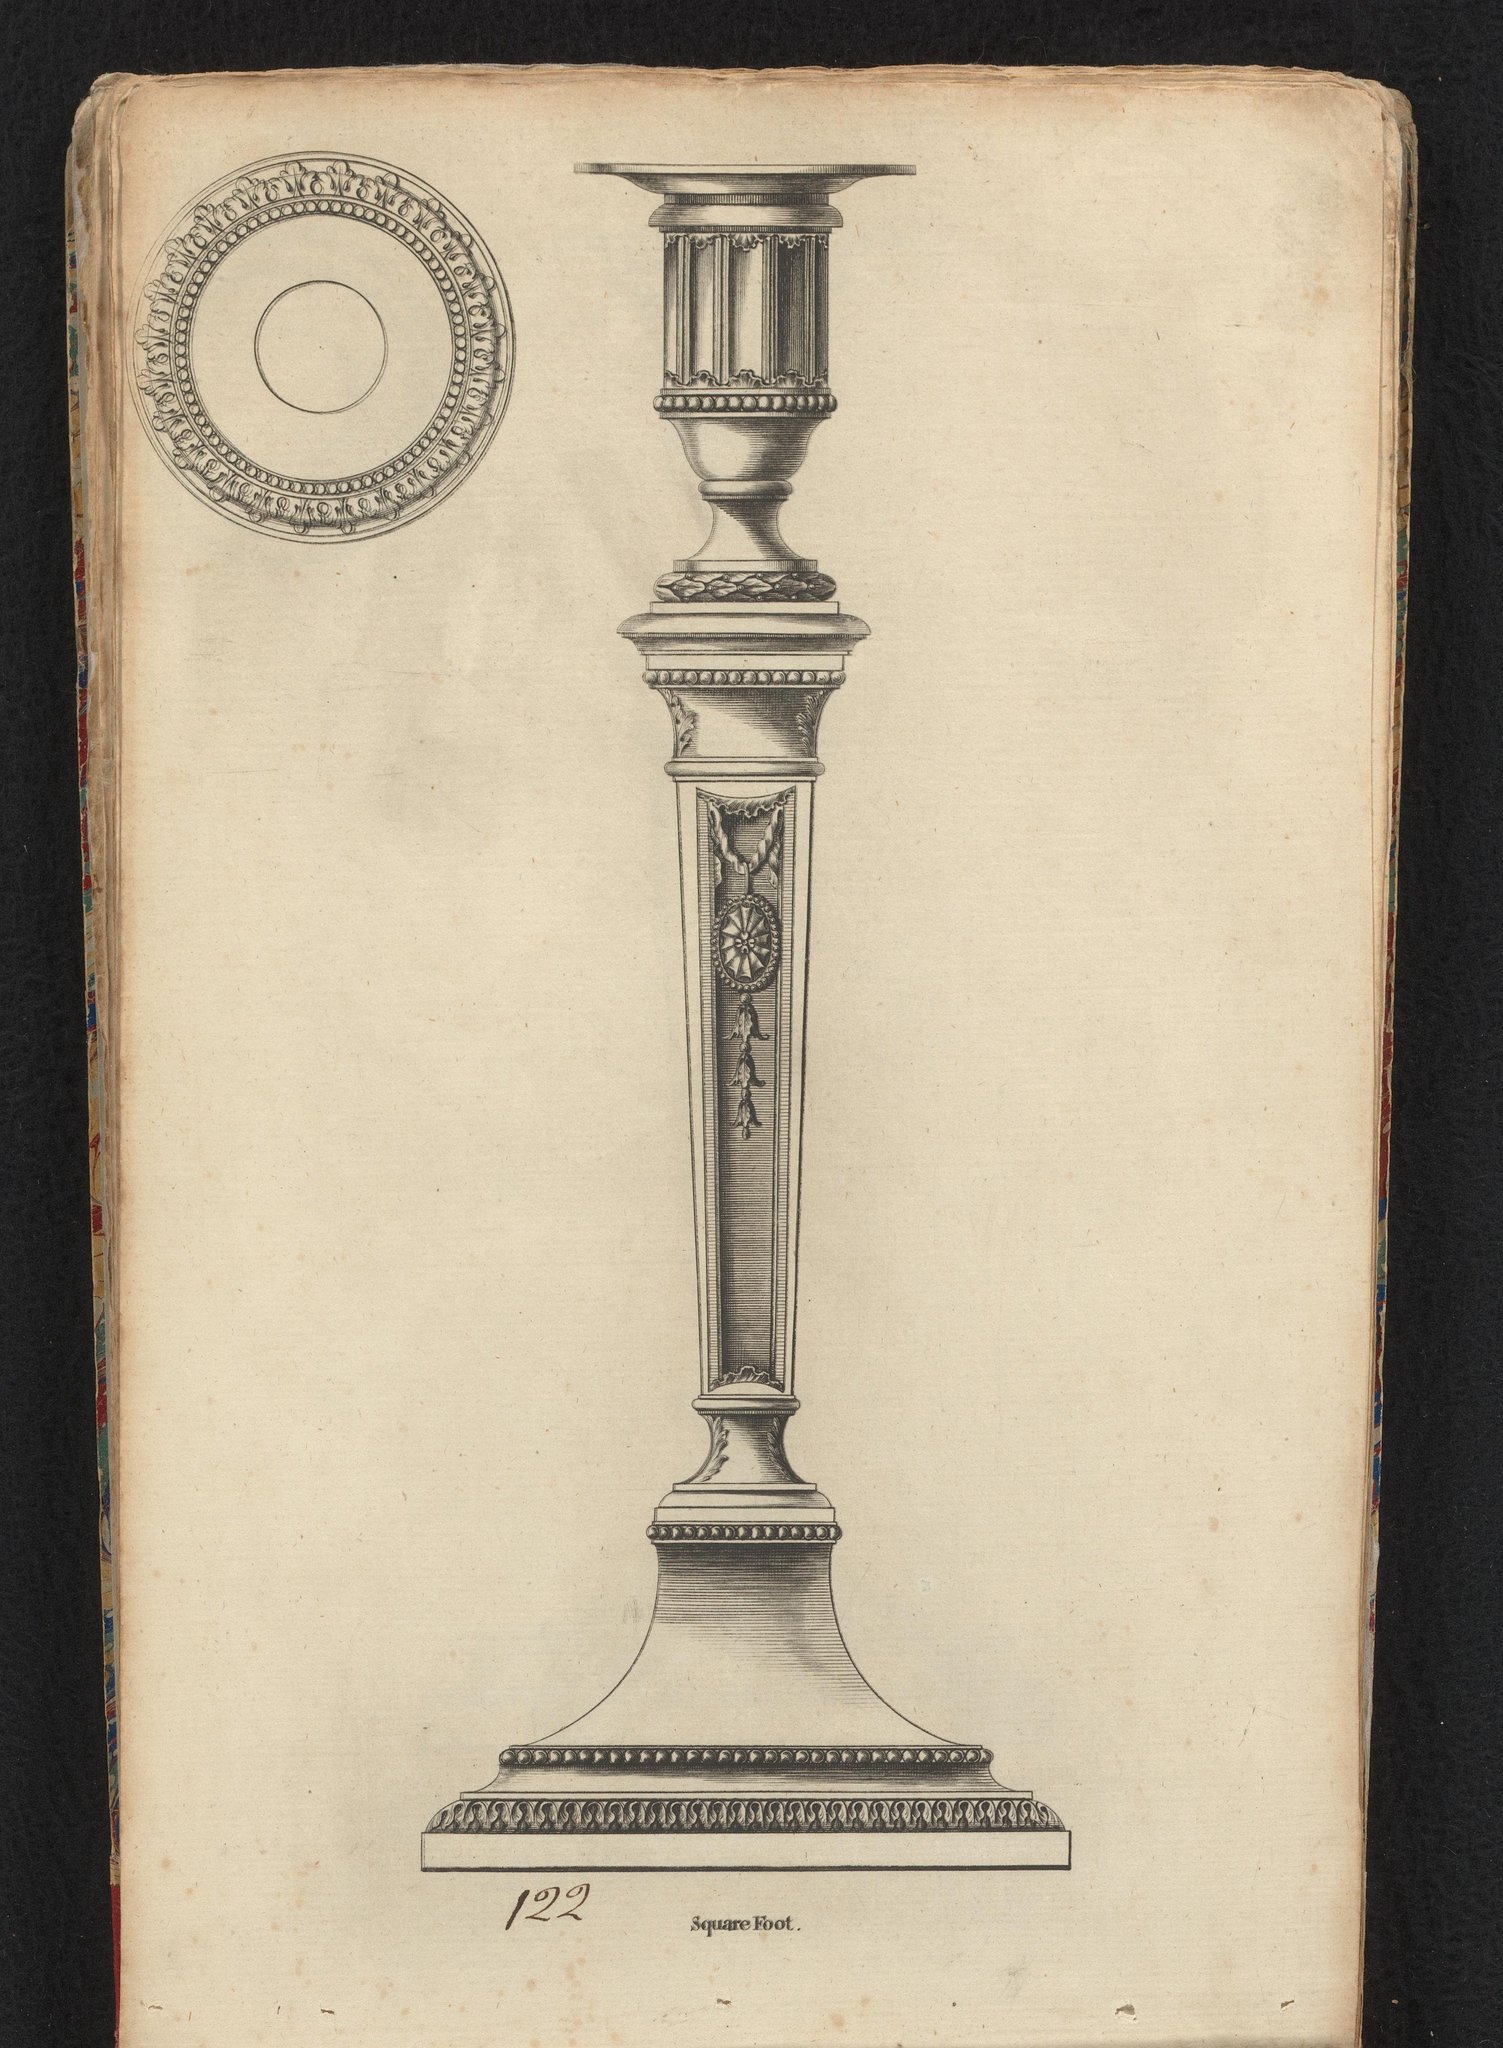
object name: print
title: Ontwerp voor een kandelaar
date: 1784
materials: paper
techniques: engraving, etching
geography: england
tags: candlestick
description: Ontwerp voor een kandelaar met een ronde voet, op het volle blad. Met detail van de voet. Met gedrukt onderschrift en handgeschreven nr. 122. Onderdeel van een catalogus met assortiment modellen van Sheffield verzilverd vaatwerk (pleet) door Matthew Boulton.